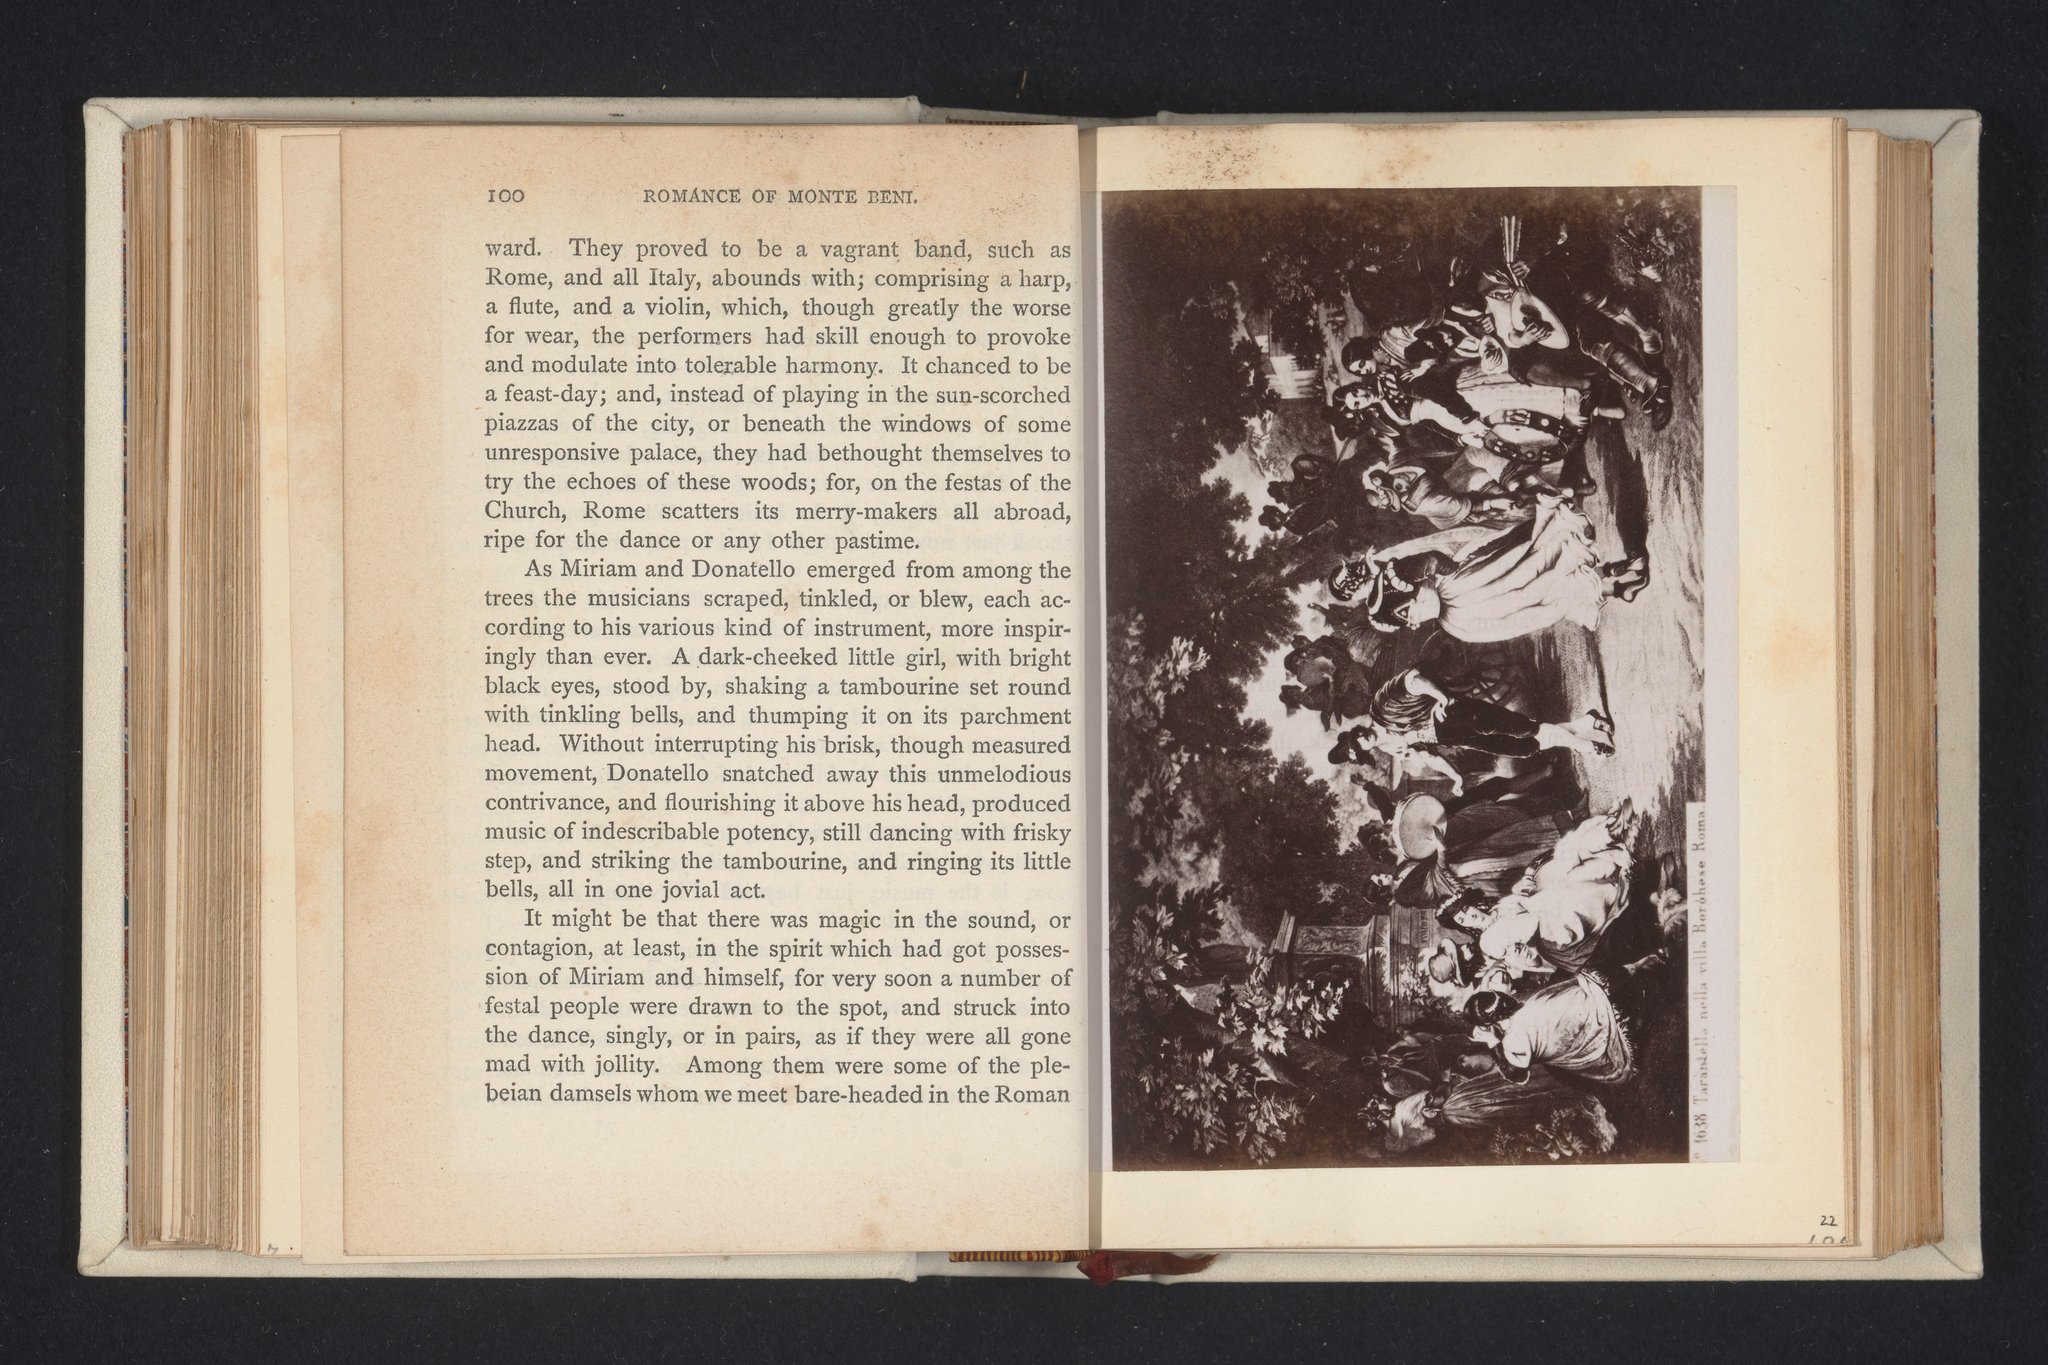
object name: photograph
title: Fotoreproductie van een schilderij van mensen die de Tarantella dansen in de tuin van Villa Borghese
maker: Anonymous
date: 1850-1860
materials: photographic support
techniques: albumen print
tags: folk dancing (men and women together)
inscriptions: number: ‘1638 Tarantella nella villa Borghese Roma’